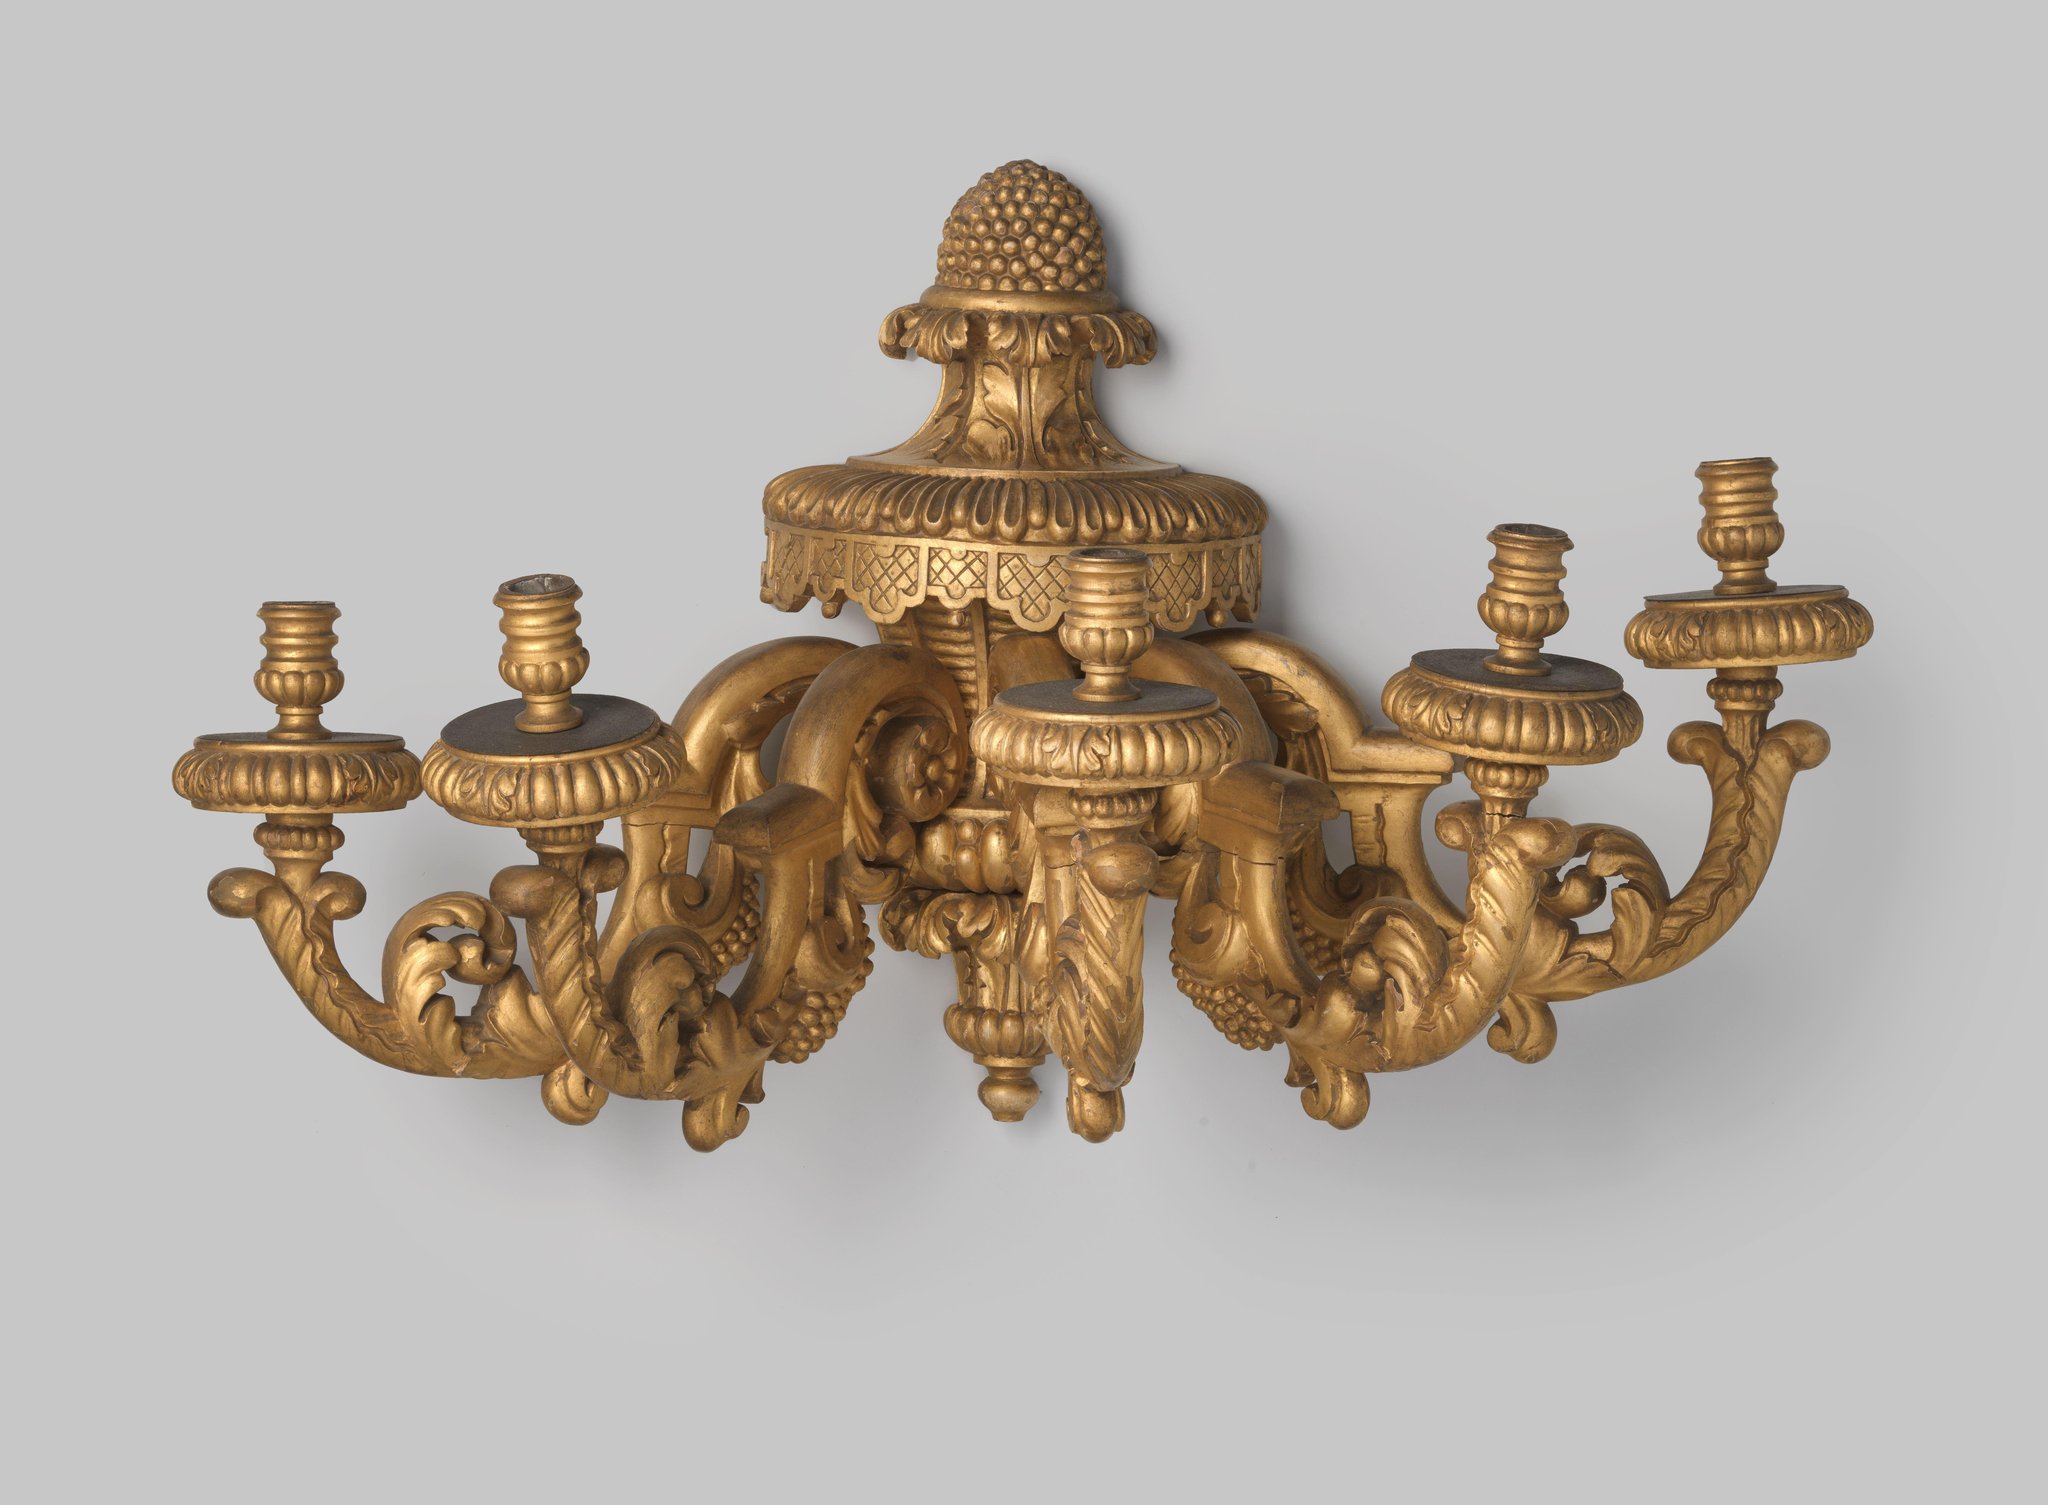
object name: wandluchter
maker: Anonymous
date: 1700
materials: copper, wood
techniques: gilding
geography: netherlands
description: Wandluchter van verguld lindehout. De vijf armen bestaan uit gebroken acanthusvoluten ; kaarsenhouders en vetvangers zijn met knorren versierd. De vaasvormige stam is met een lambrequin bedekt en wordt bekroond door acanthusbladeren met een vrucht als knop. De kaarsenhouders zijn van koper. Zie tevens BK-NM-9804-a en b.